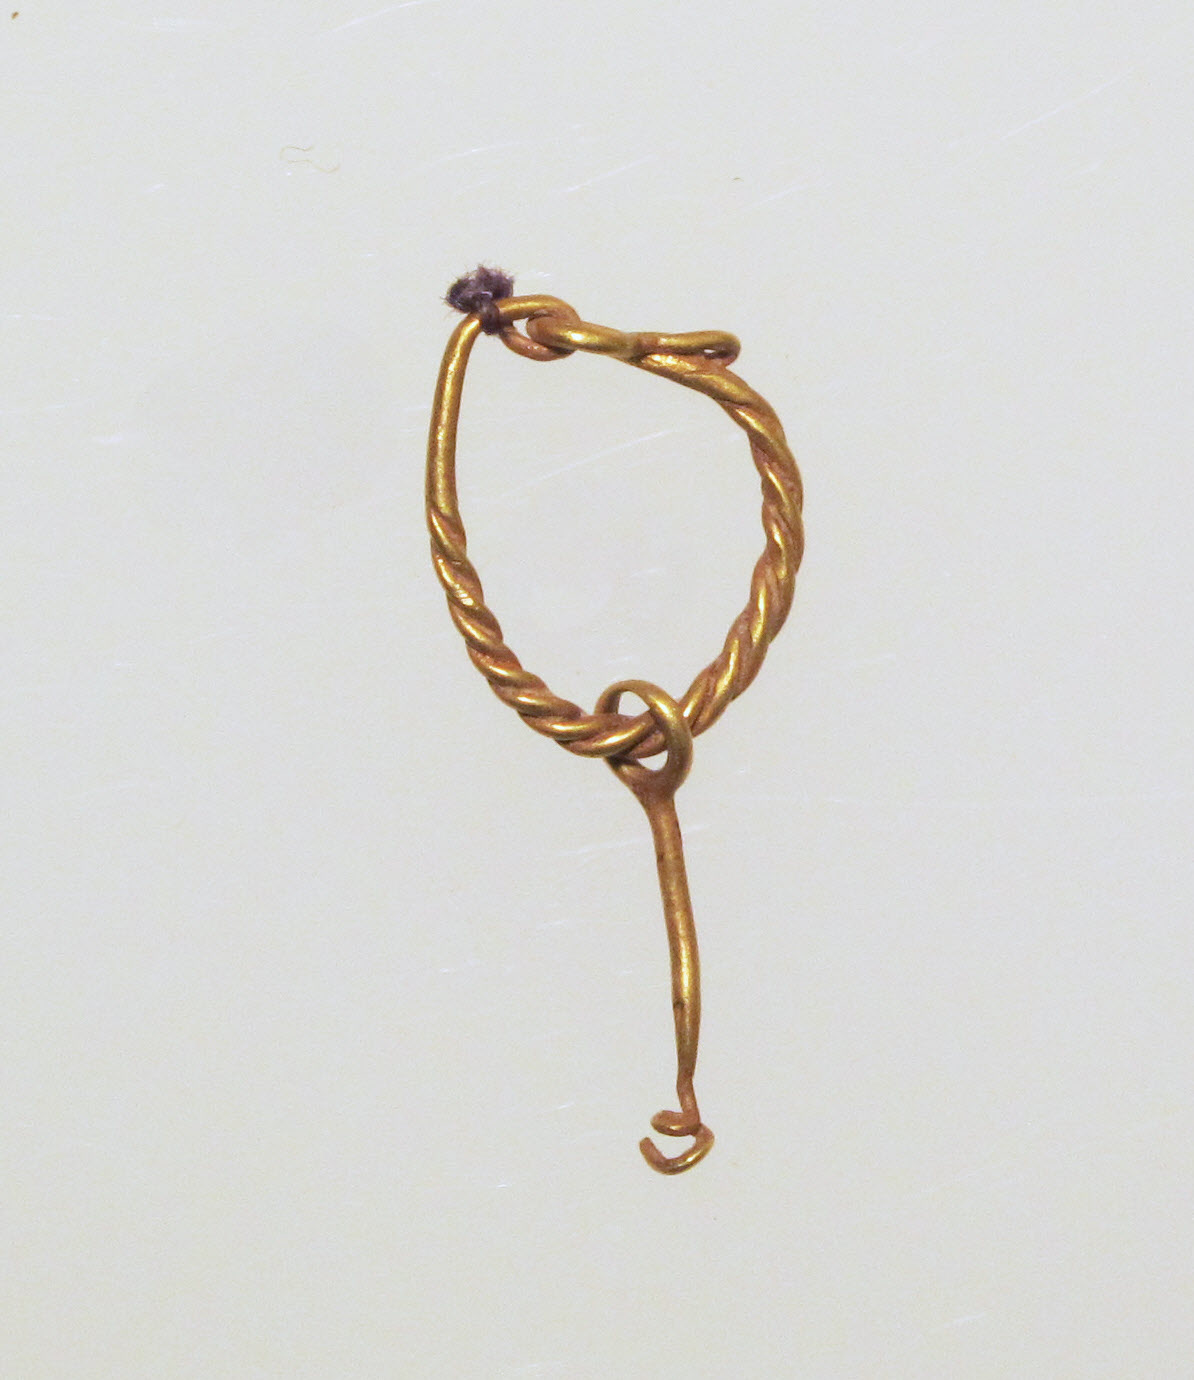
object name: earring with pendant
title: Gold earring with pendant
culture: roman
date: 101-200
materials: gold